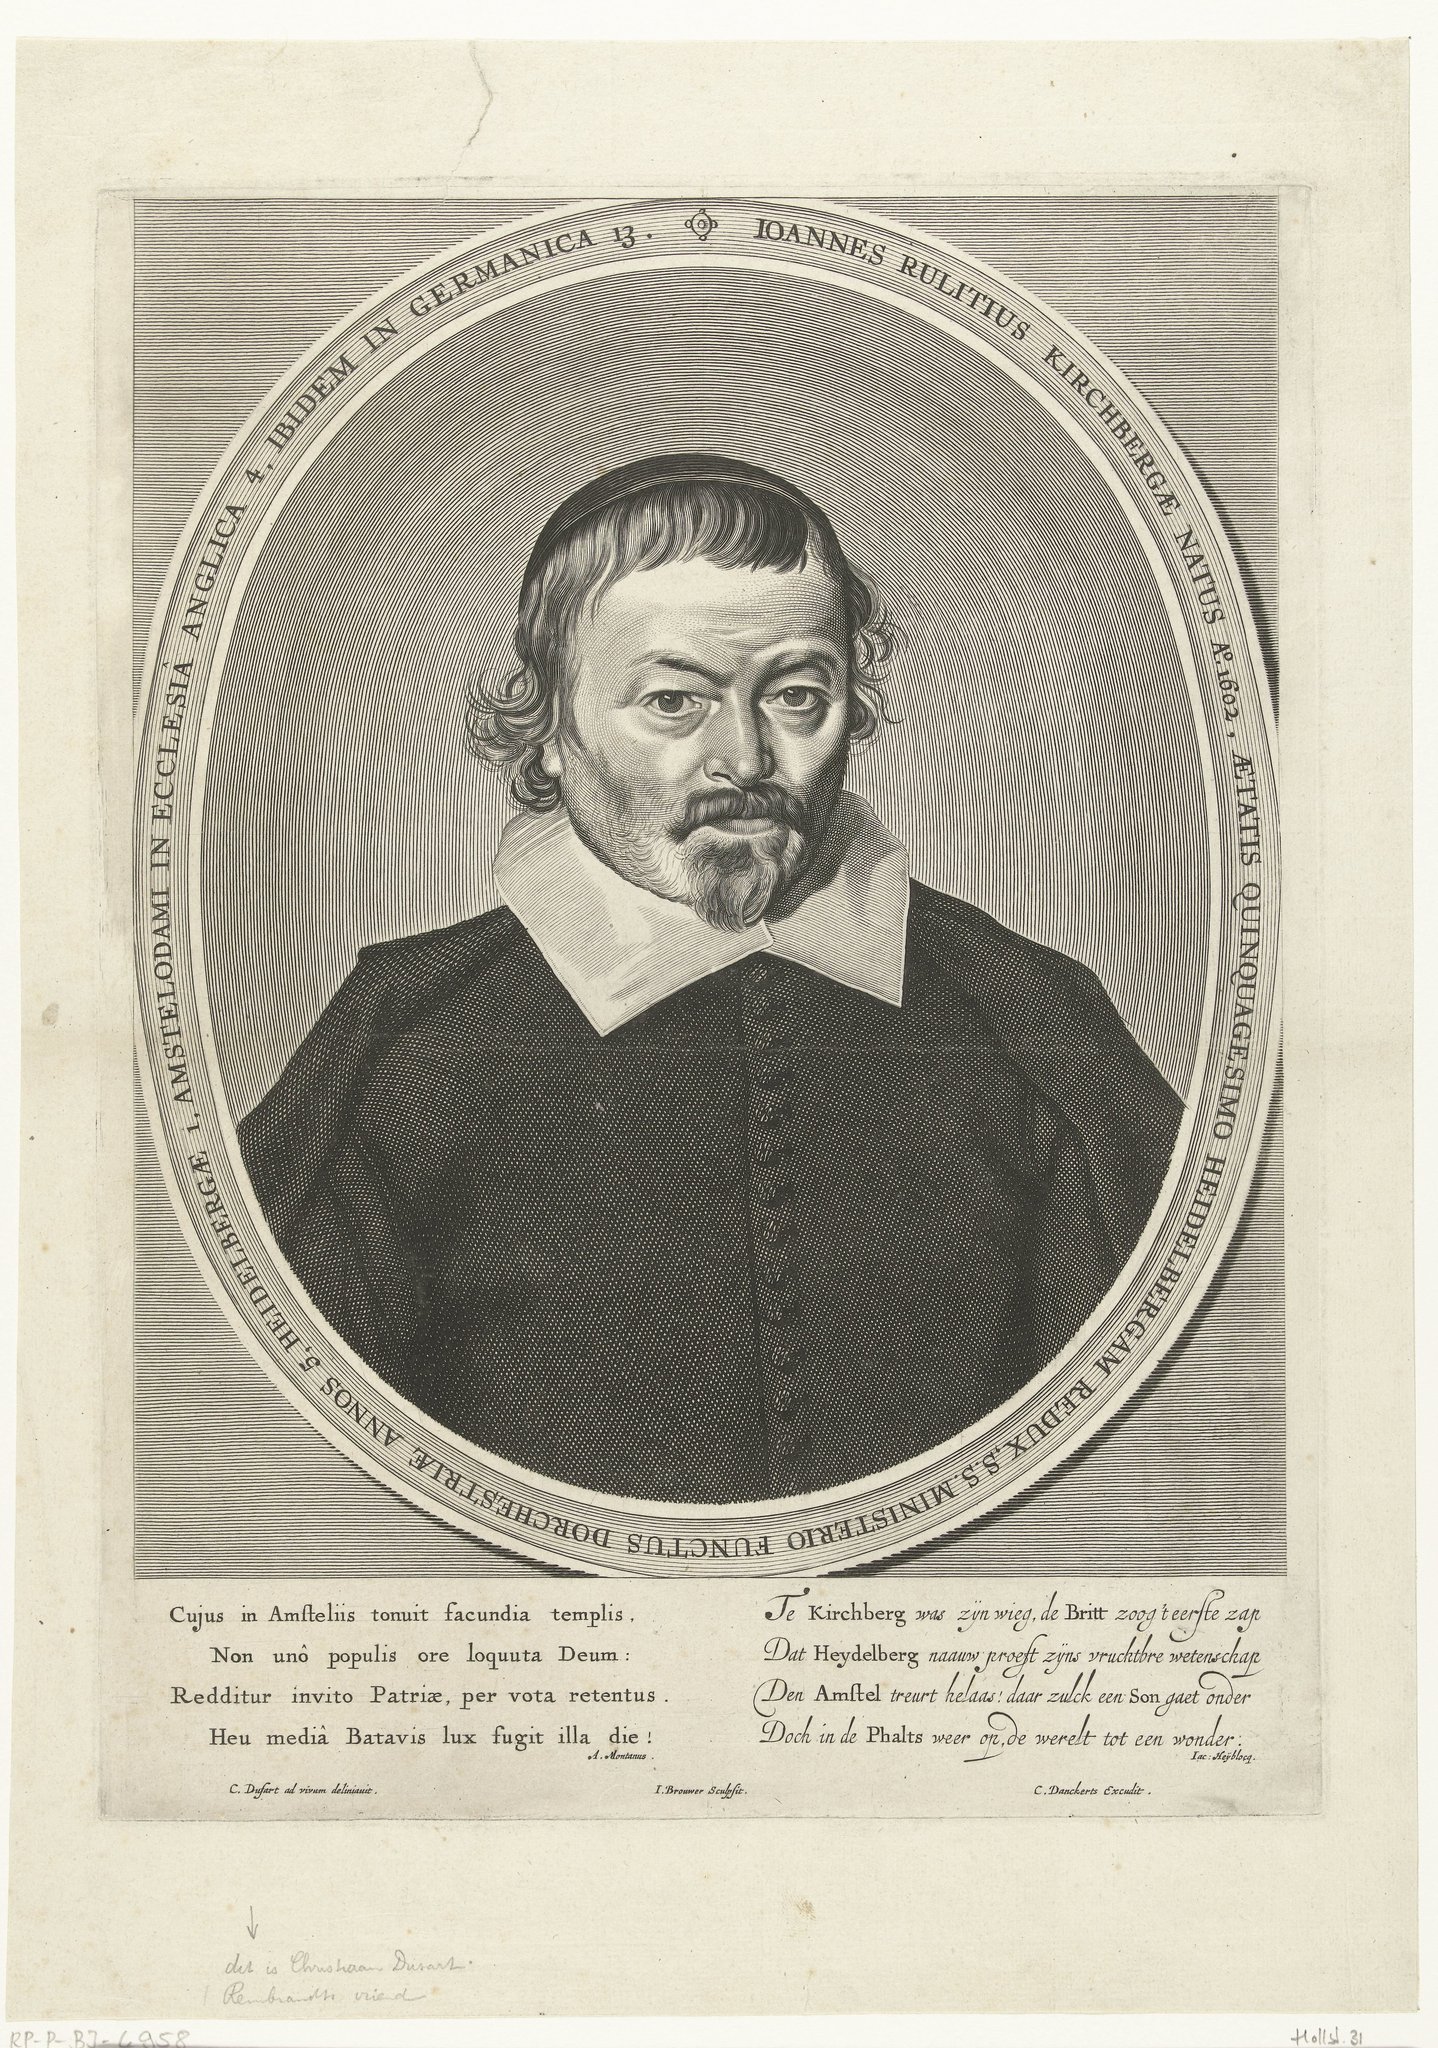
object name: print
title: Portret van de predikant Johannes Rulitius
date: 1652-1656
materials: paper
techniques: engraving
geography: amsterdam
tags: kirchberg, johannes rulitius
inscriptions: collector's mark: Lugt 240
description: In het opschrift rond de prent wordt de leeftijd van hier geportretteerde Johannes Rulitius (1602-1666) aangeduid als 'aetatis quinquigesimo', ofwel 50 jaar, de leeftijd die hij in 1652 bereikte. De prent zal rond die tijd zijn gemaakt. Daarmee is Cornelis Dusart (1660-1704) als maker van de ontwerptekening uitgesloten, evenals Cornelis Danckerts II (1664-1717) als uitgever. De ontwerper is Christiaen Jansz. Dusart, van wie meer van dergelijke ontwerpen bekend zijn, en Cornelis Danckerts (1604-1656).